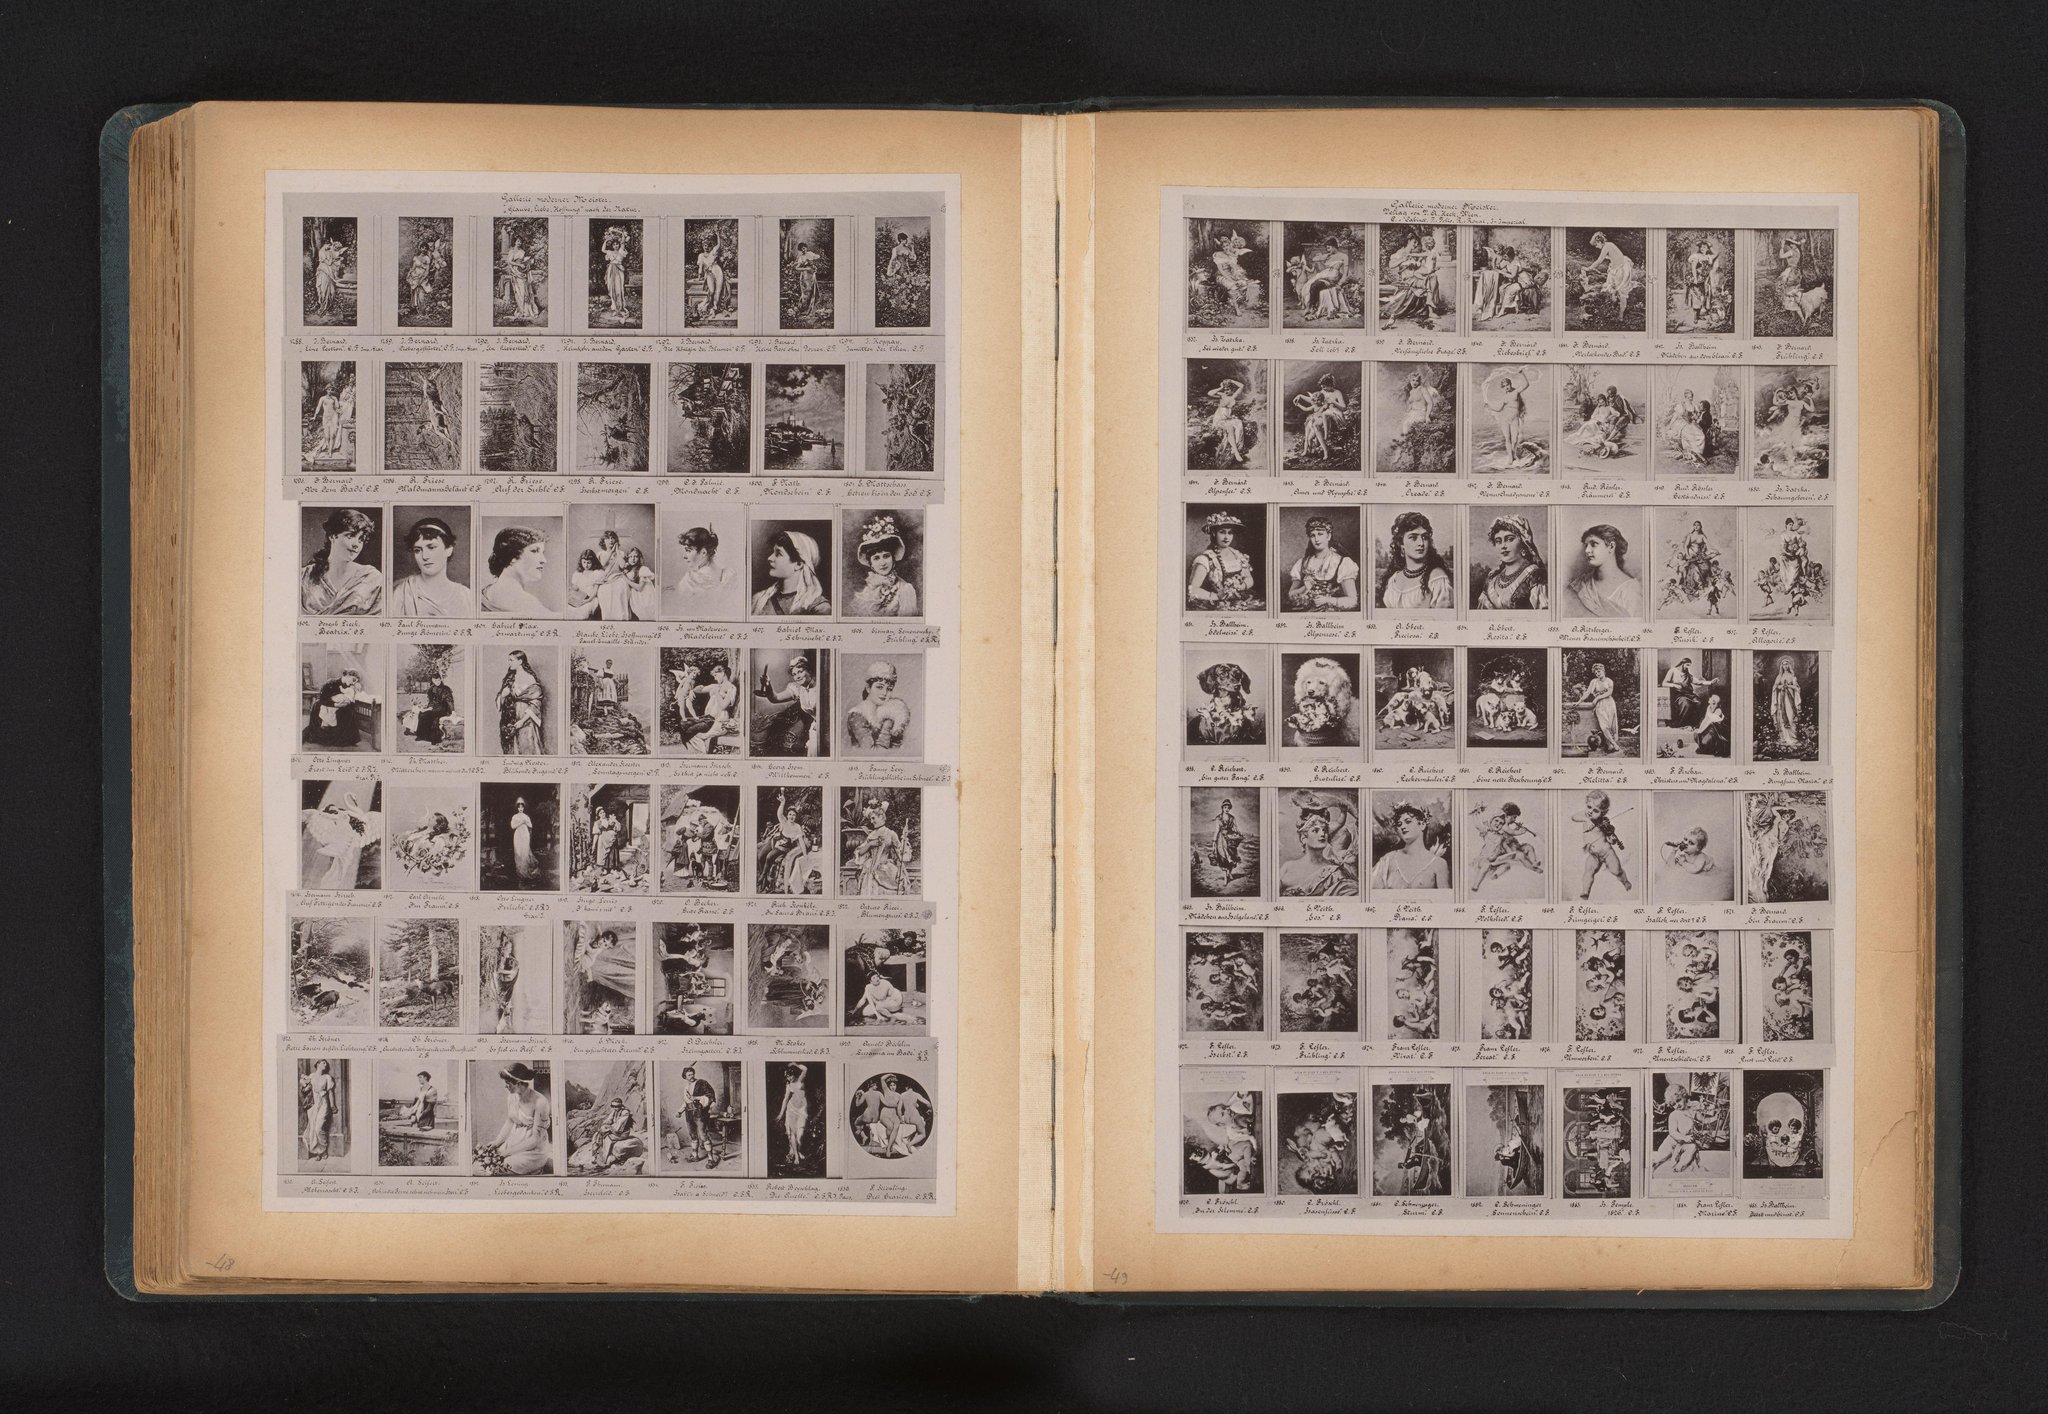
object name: reproduction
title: Fotoreproducties van geschilderde portretten en taferelen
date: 1880-1885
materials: paper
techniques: photograph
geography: berlin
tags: historical persons not known by name - bb - woman, historical persons not known by name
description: Prent op negenenveertigste ongenummerde pagina.